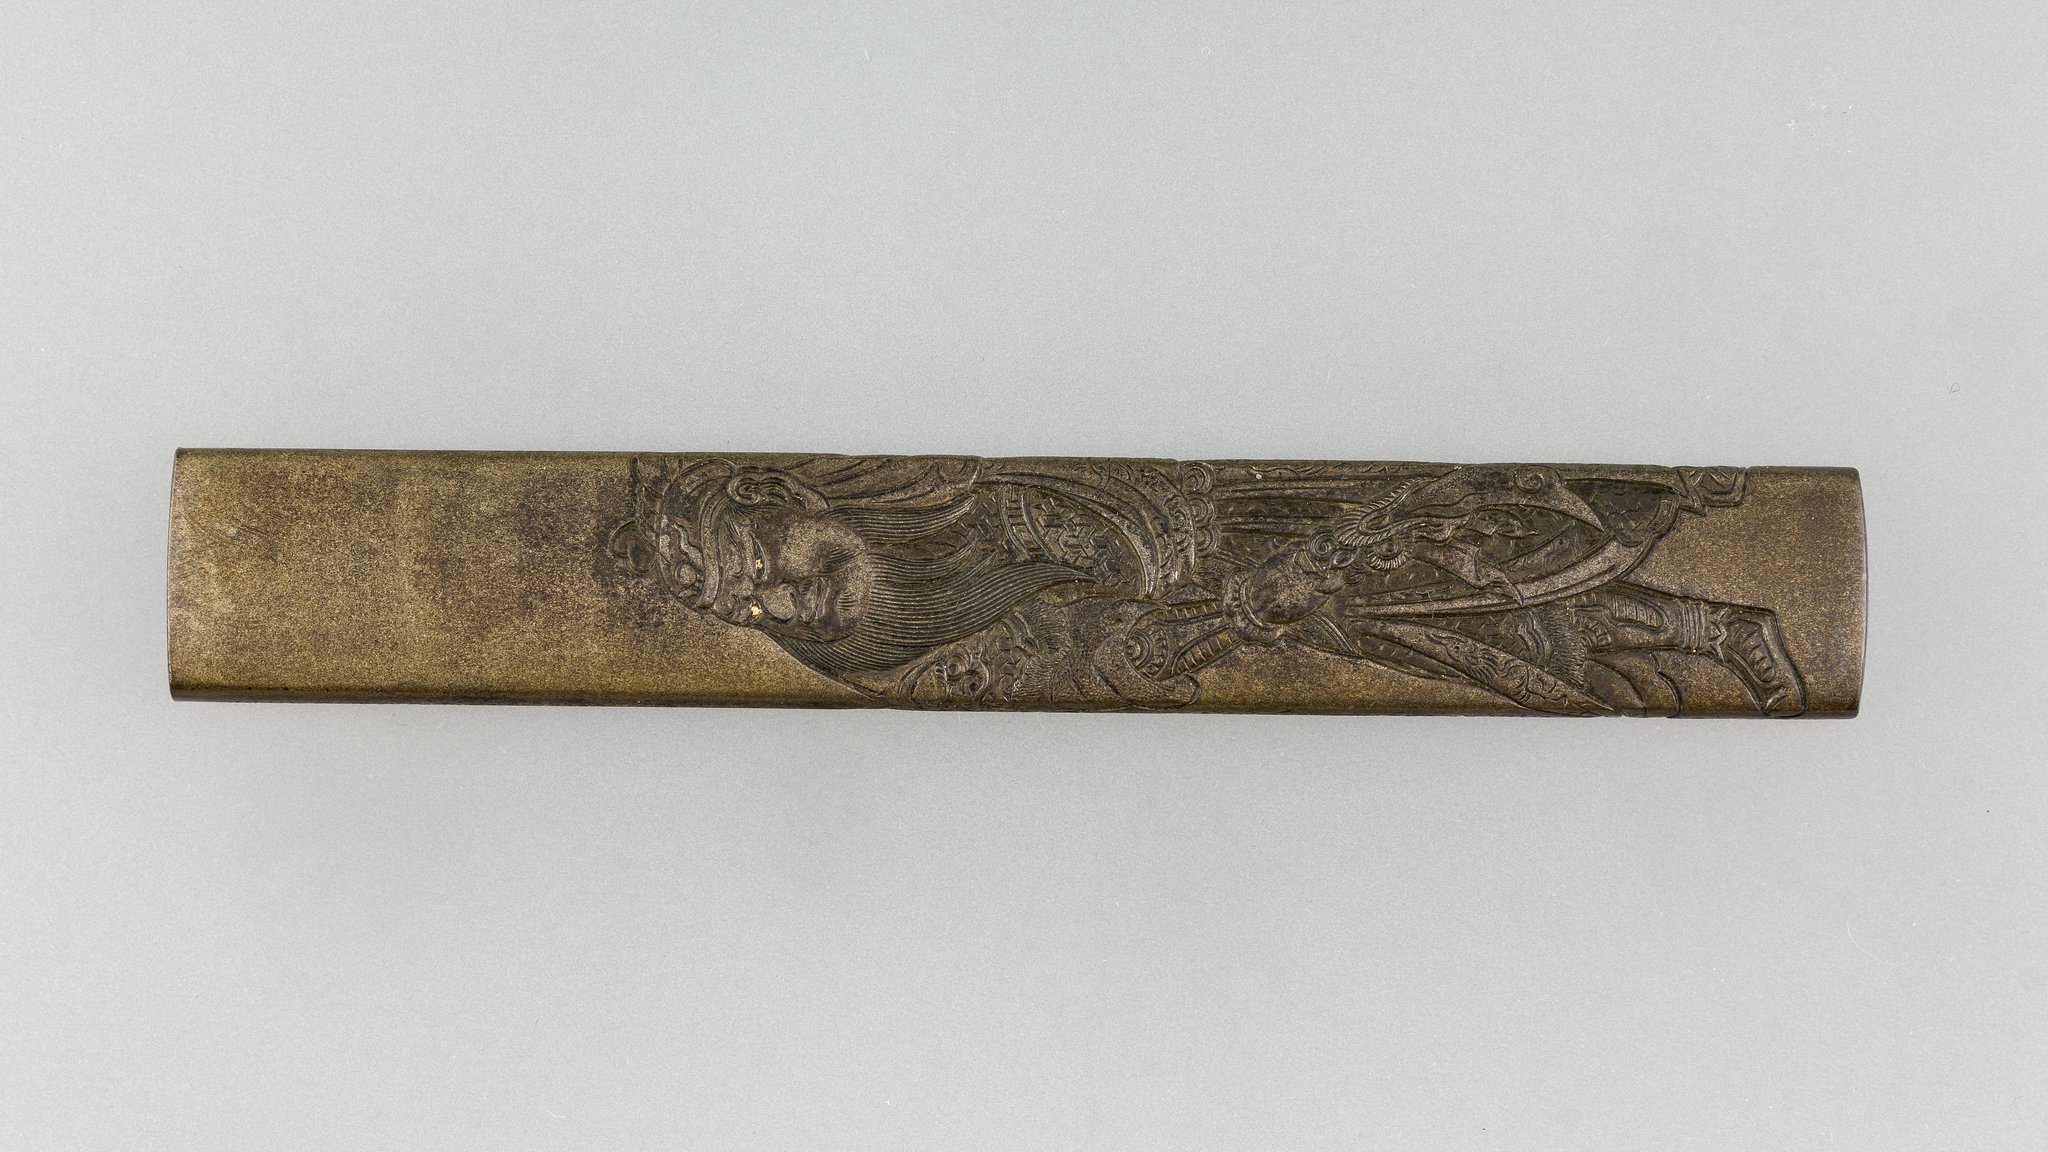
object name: knife handle kozuka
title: Knife Handle (Kozuka)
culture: japanese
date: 1701-1800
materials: silver alloy, gold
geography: japan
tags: men